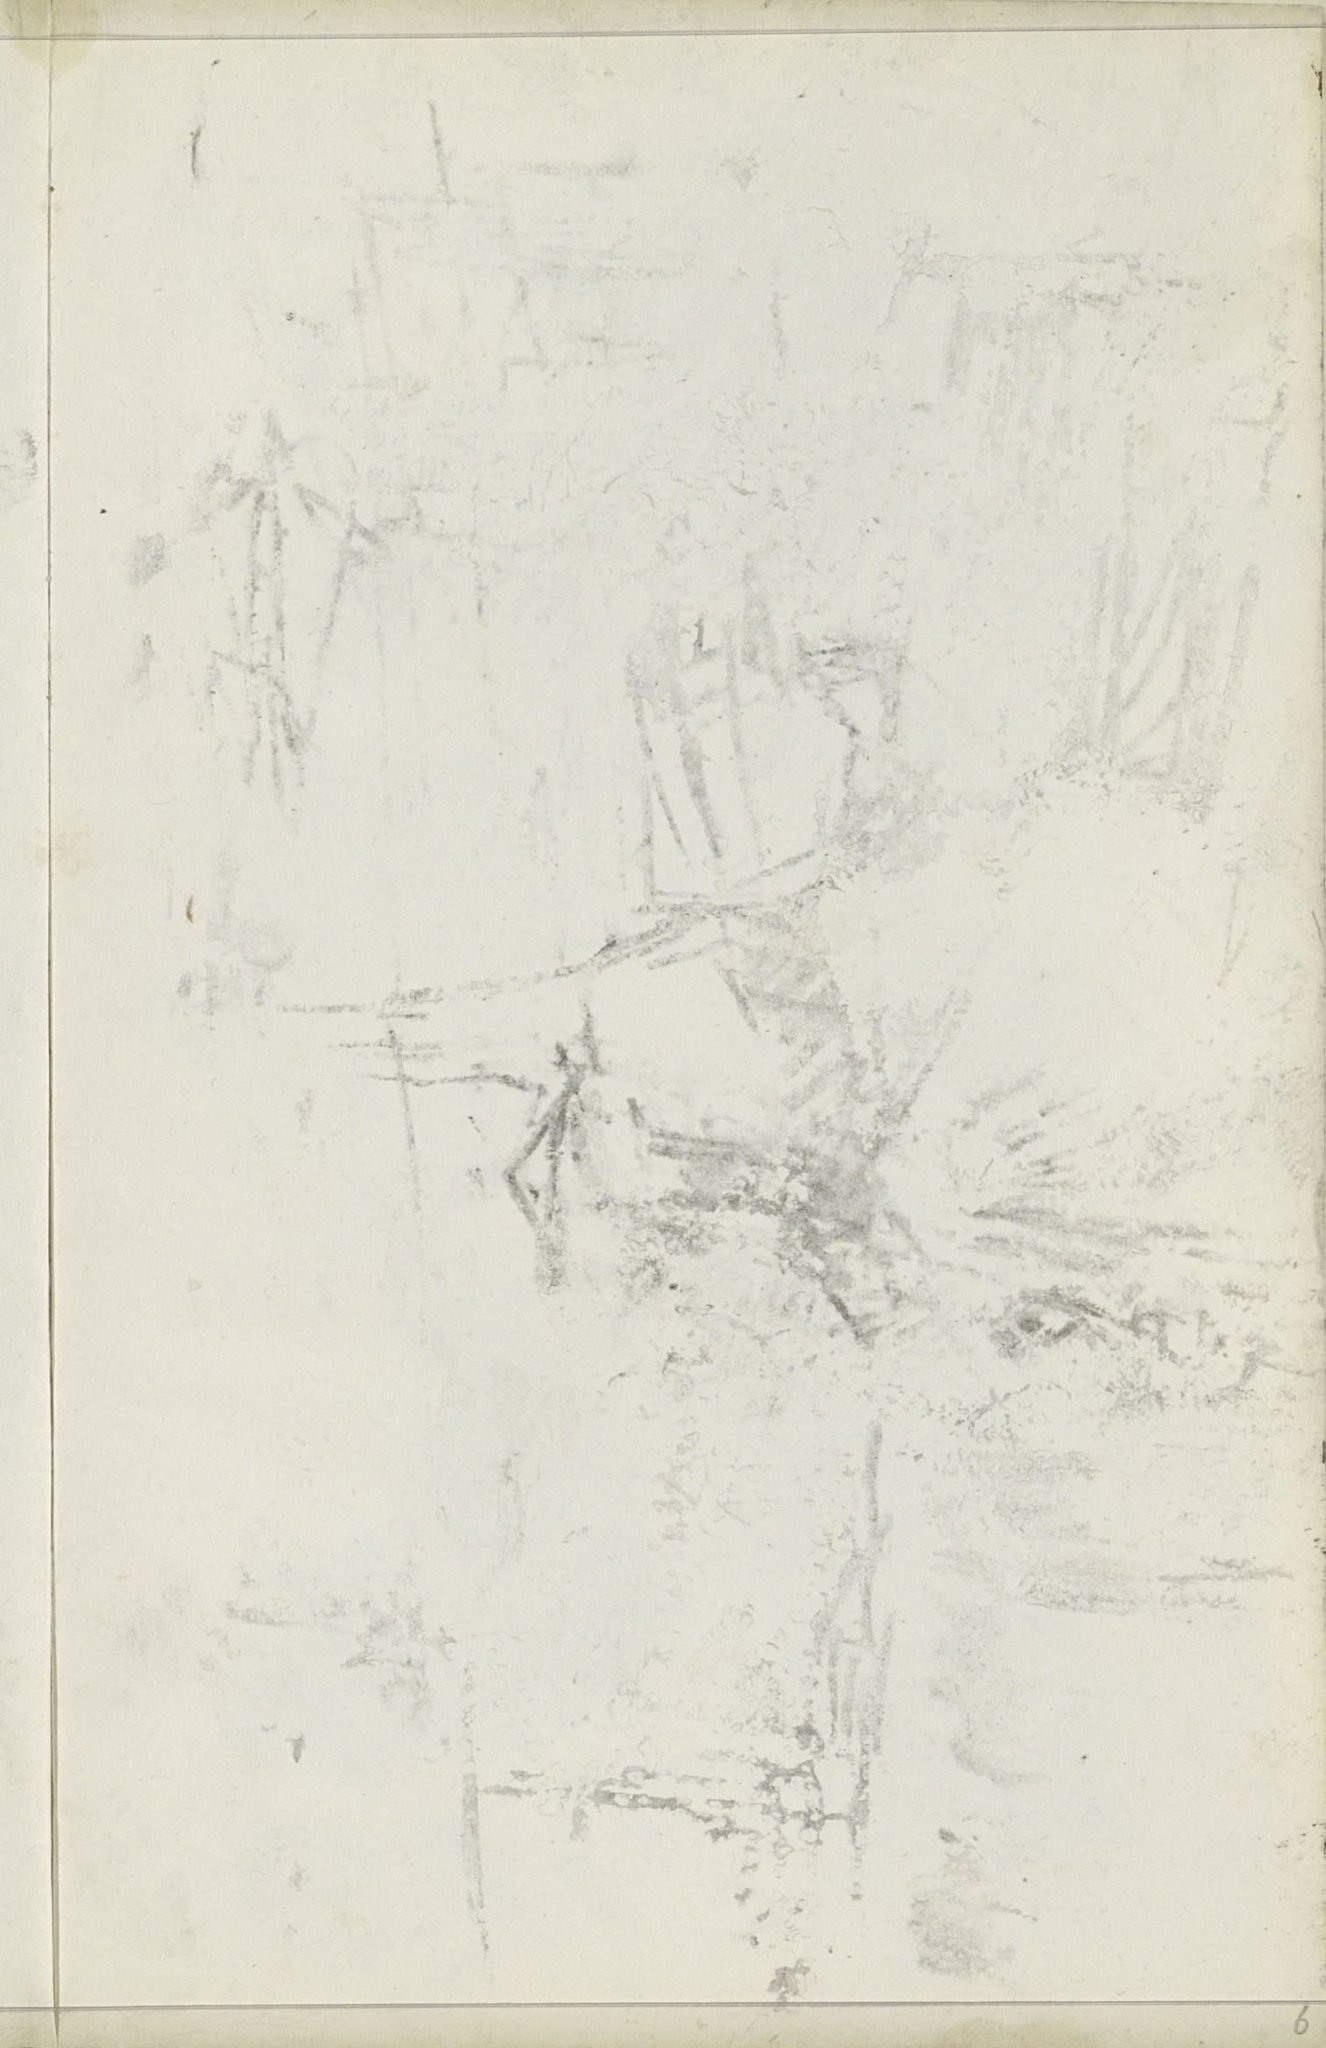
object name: sketchbook leaf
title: Abklatsch van de krijttekening op blad 5 verso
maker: isaac israels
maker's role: draughtsman, painter, print maker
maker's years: 1865-1934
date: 1875-1934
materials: paper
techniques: printmaking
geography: london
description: Pagina 21 en pagina 22 uit schetsboek XXXV met 36 pagina's.